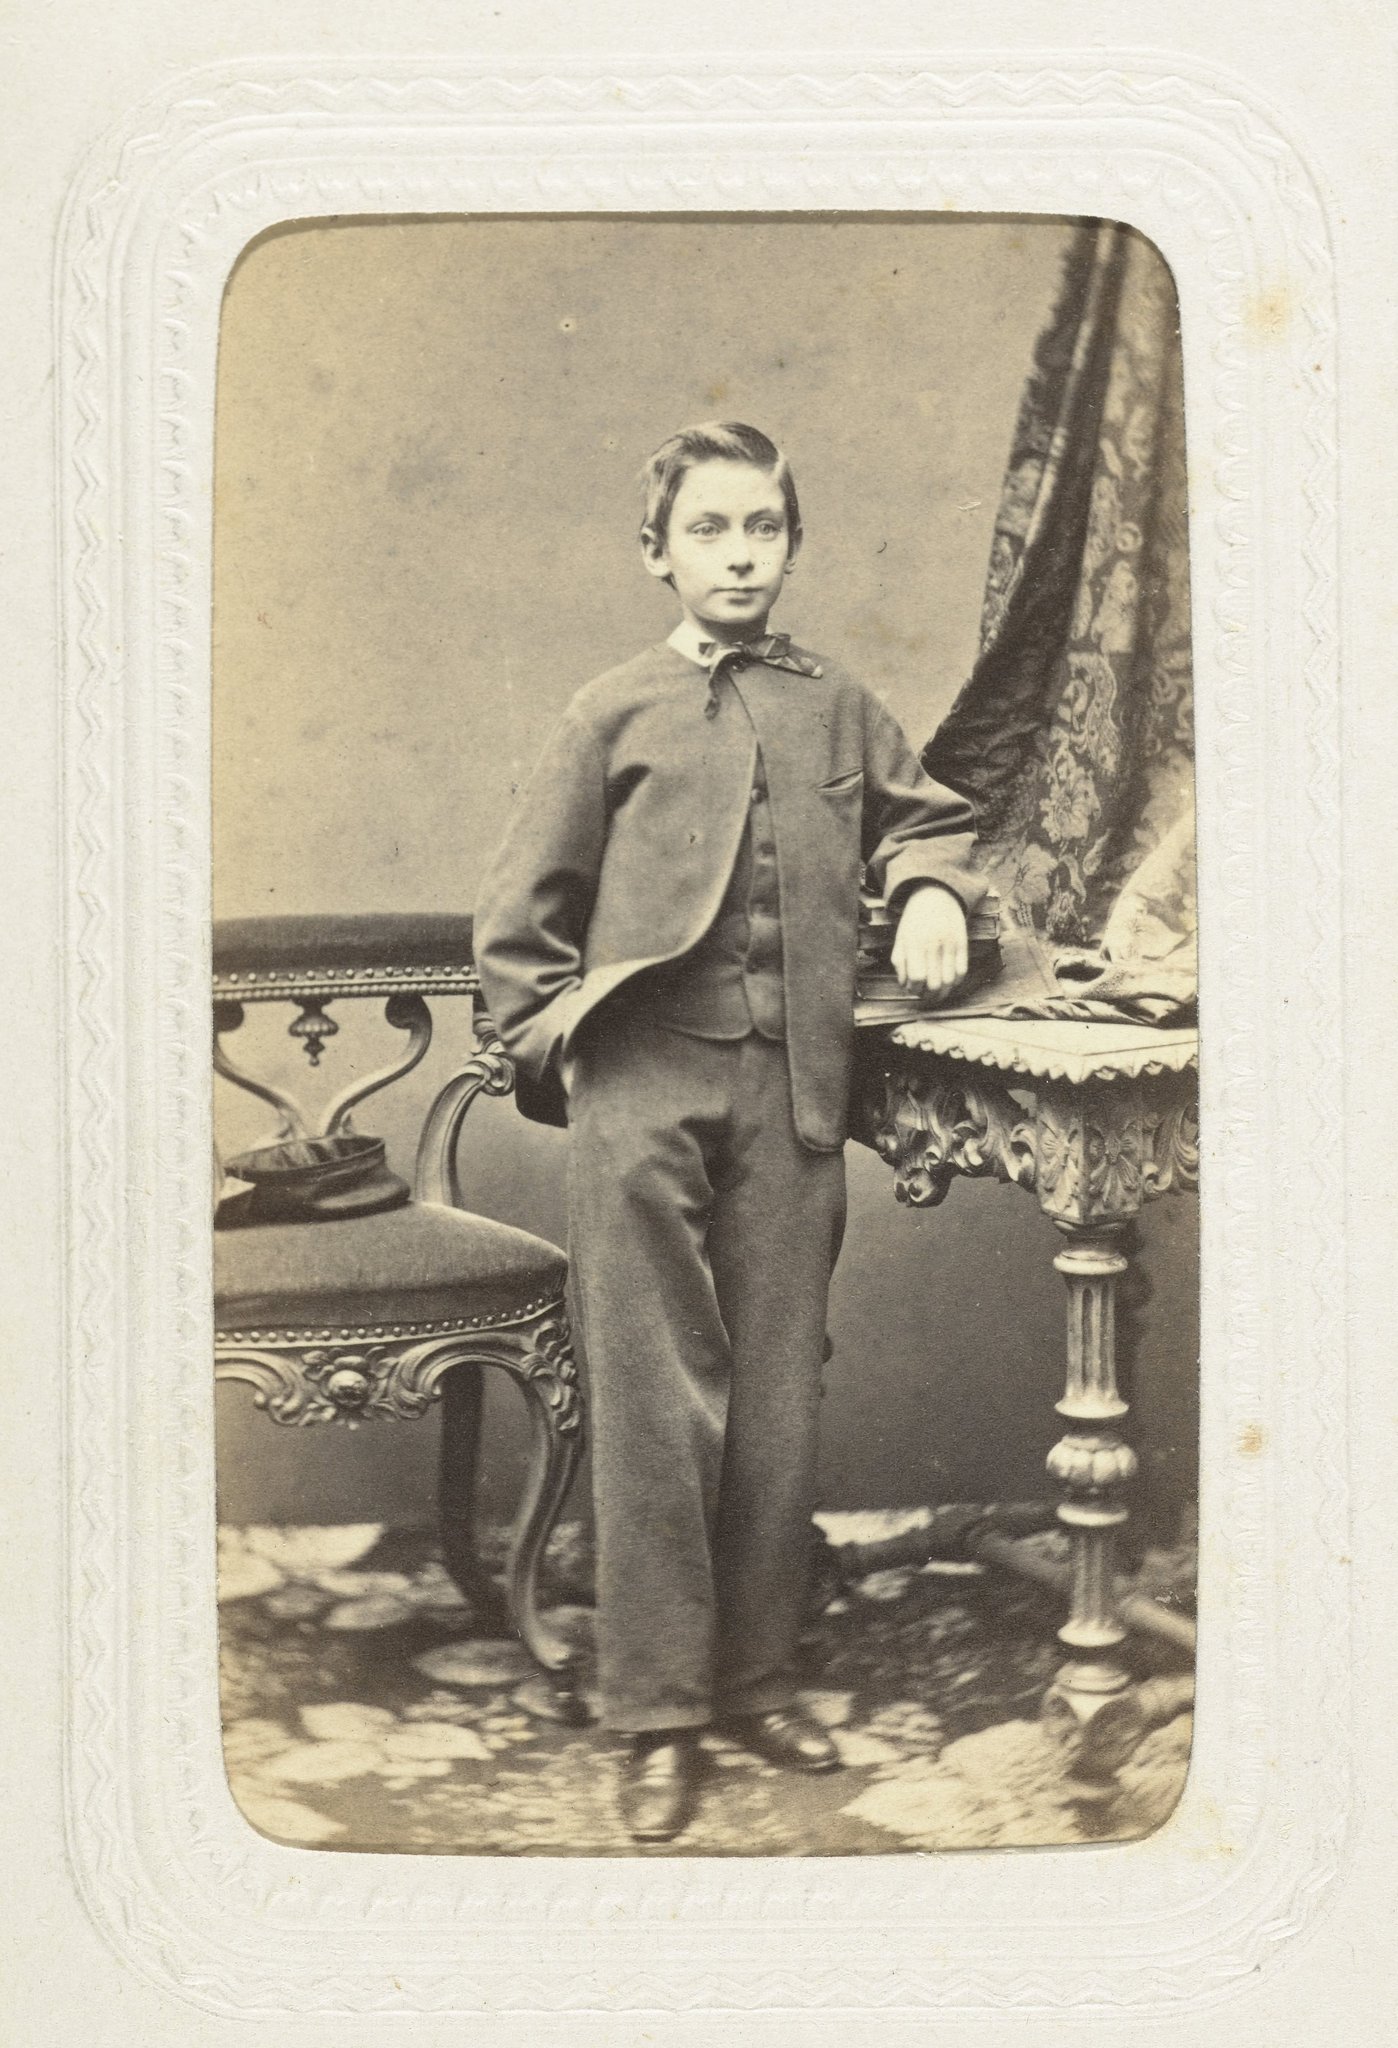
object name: carte de visite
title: Studioportret van een jongen in drie delig pak naast een tafel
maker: albert greiner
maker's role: fotograaf, fotostudio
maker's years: 1833-1890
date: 1863-1866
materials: cardboard, paper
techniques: albumen print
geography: amsterdam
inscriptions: name: ‘Albert Greiner, Amsterdam’